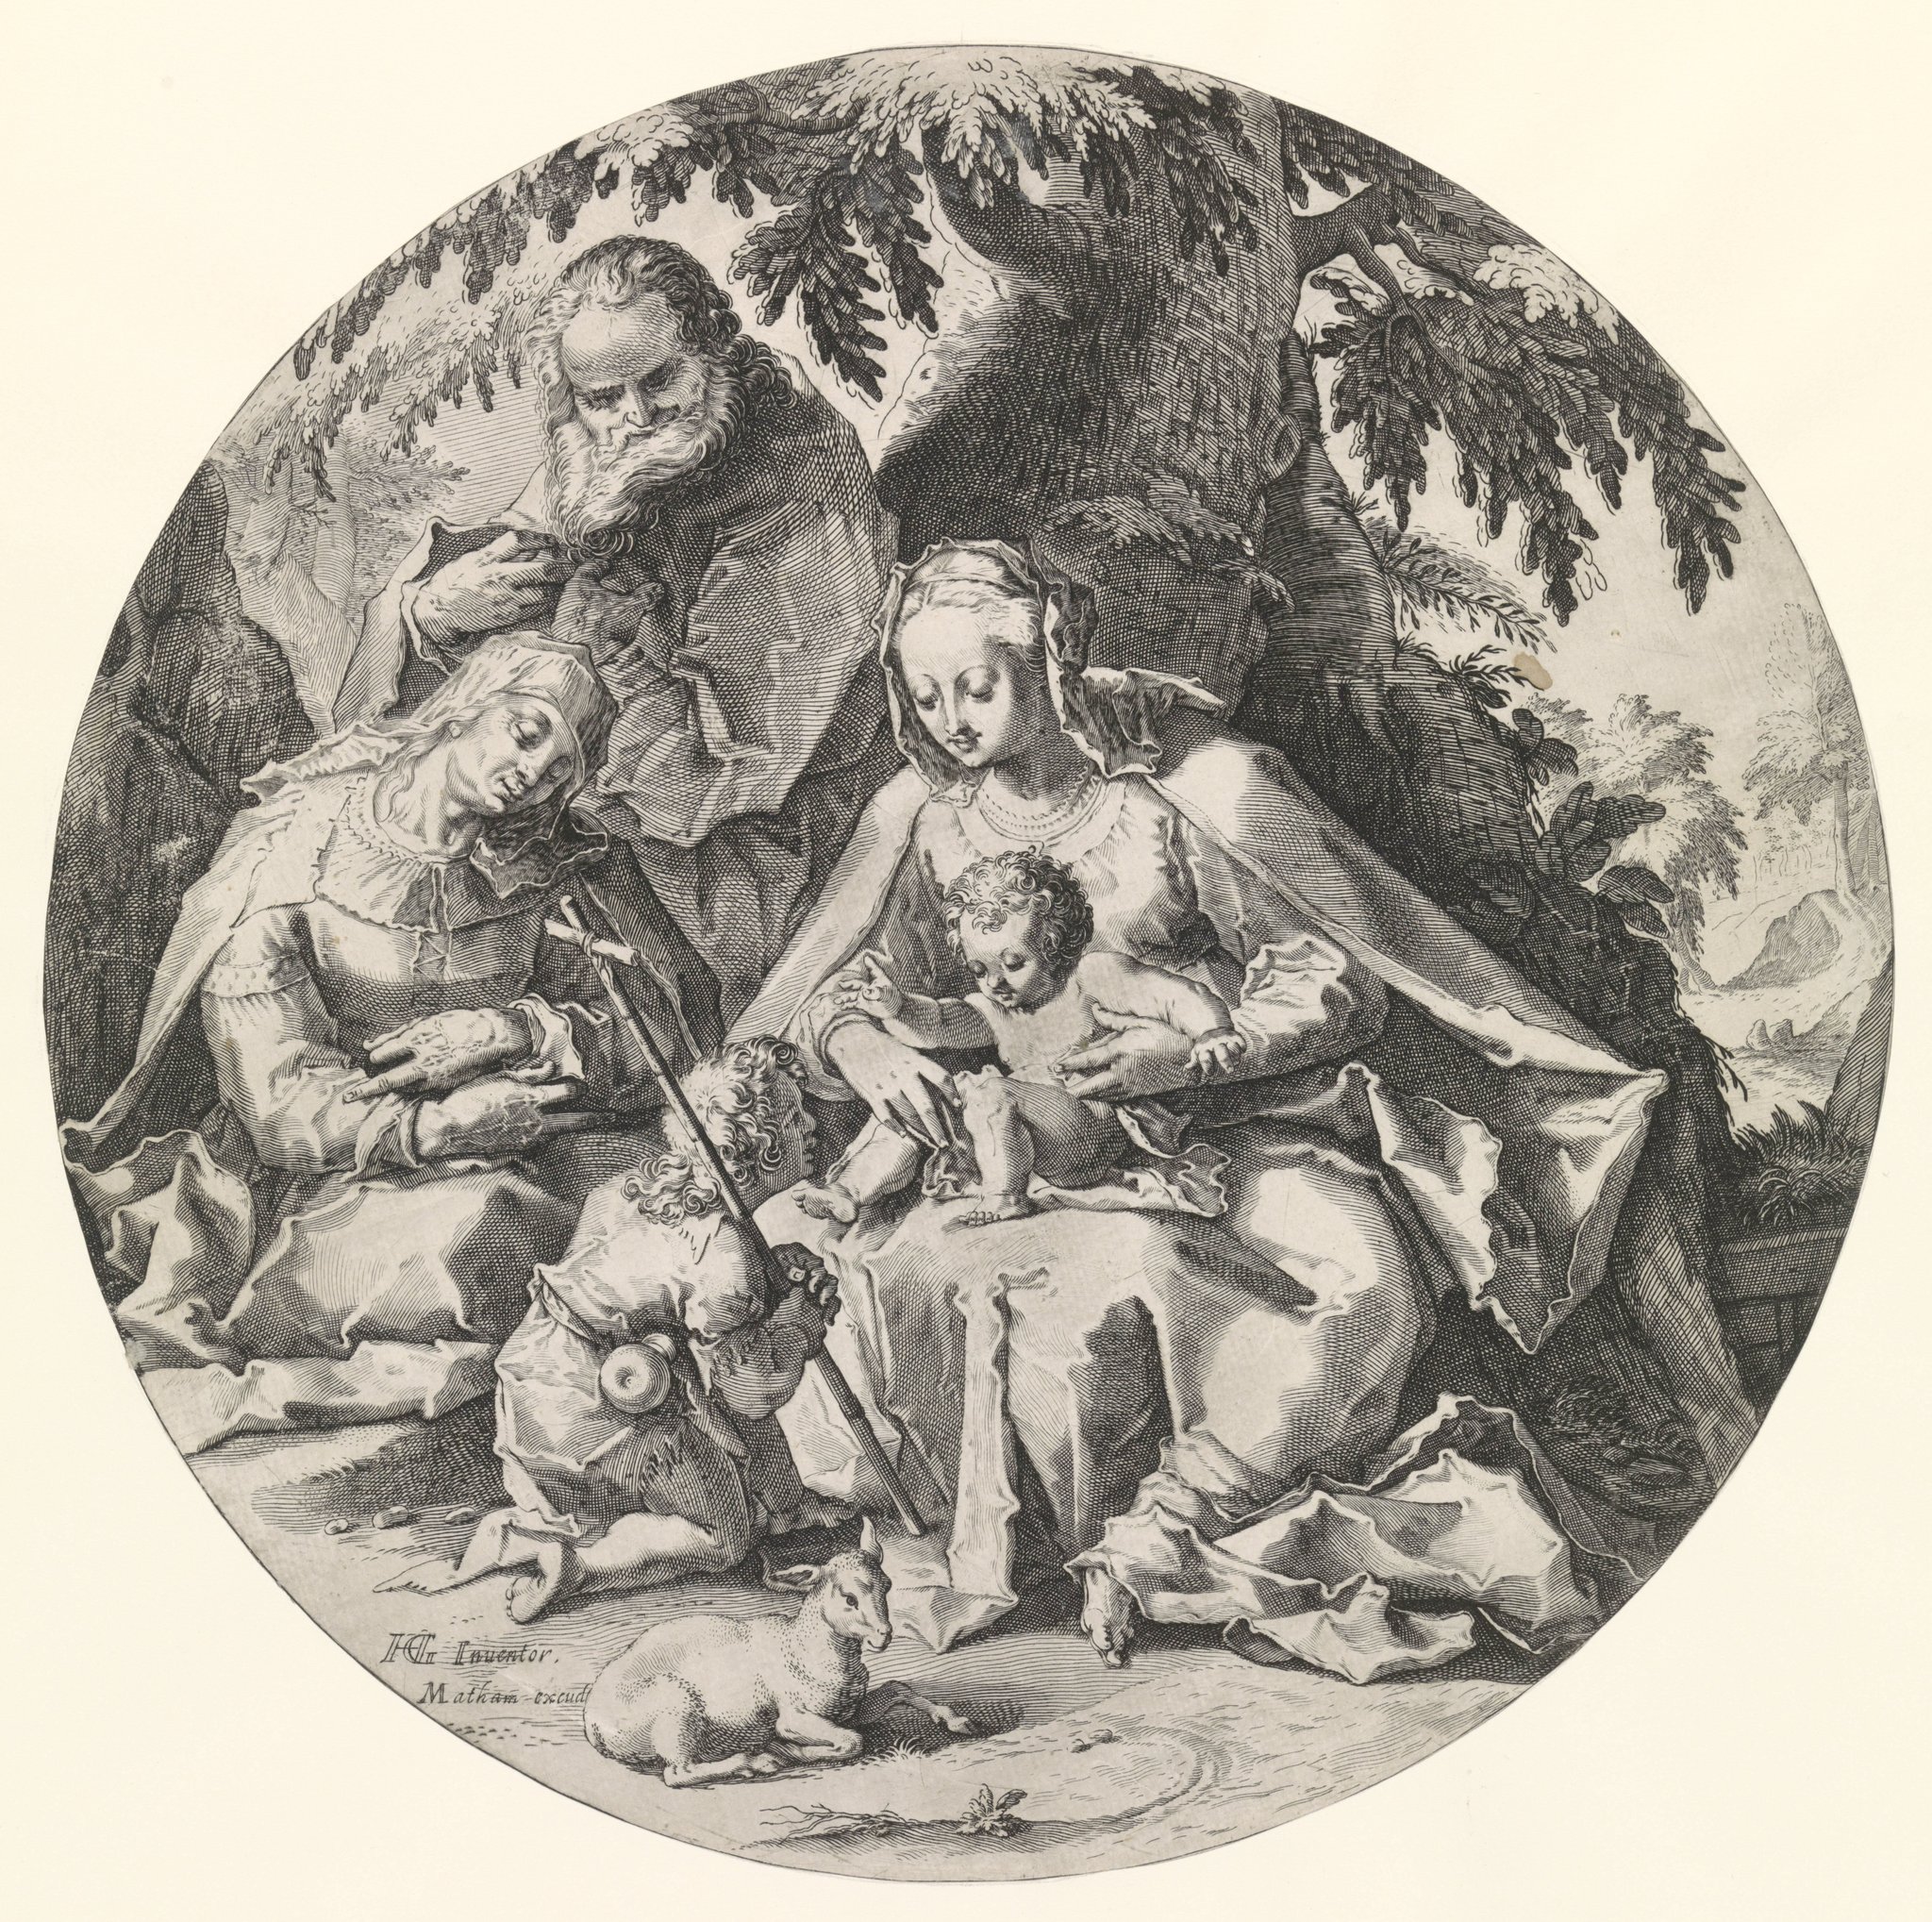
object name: print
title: Heilige Familie met Elisabet en Johannes de Doper als kind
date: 1600-1620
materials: paper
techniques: engraving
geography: haarlem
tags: adoration of the christ-child by mary, joseph, elisabeth and john the baptist, holy family, and derived representations, holy family with john the baptist, elisabeth present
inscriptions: collector's mark: Lugt 240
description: De Heilige Familie met Elisabet en Johannes de Doper als kind onder een boom.